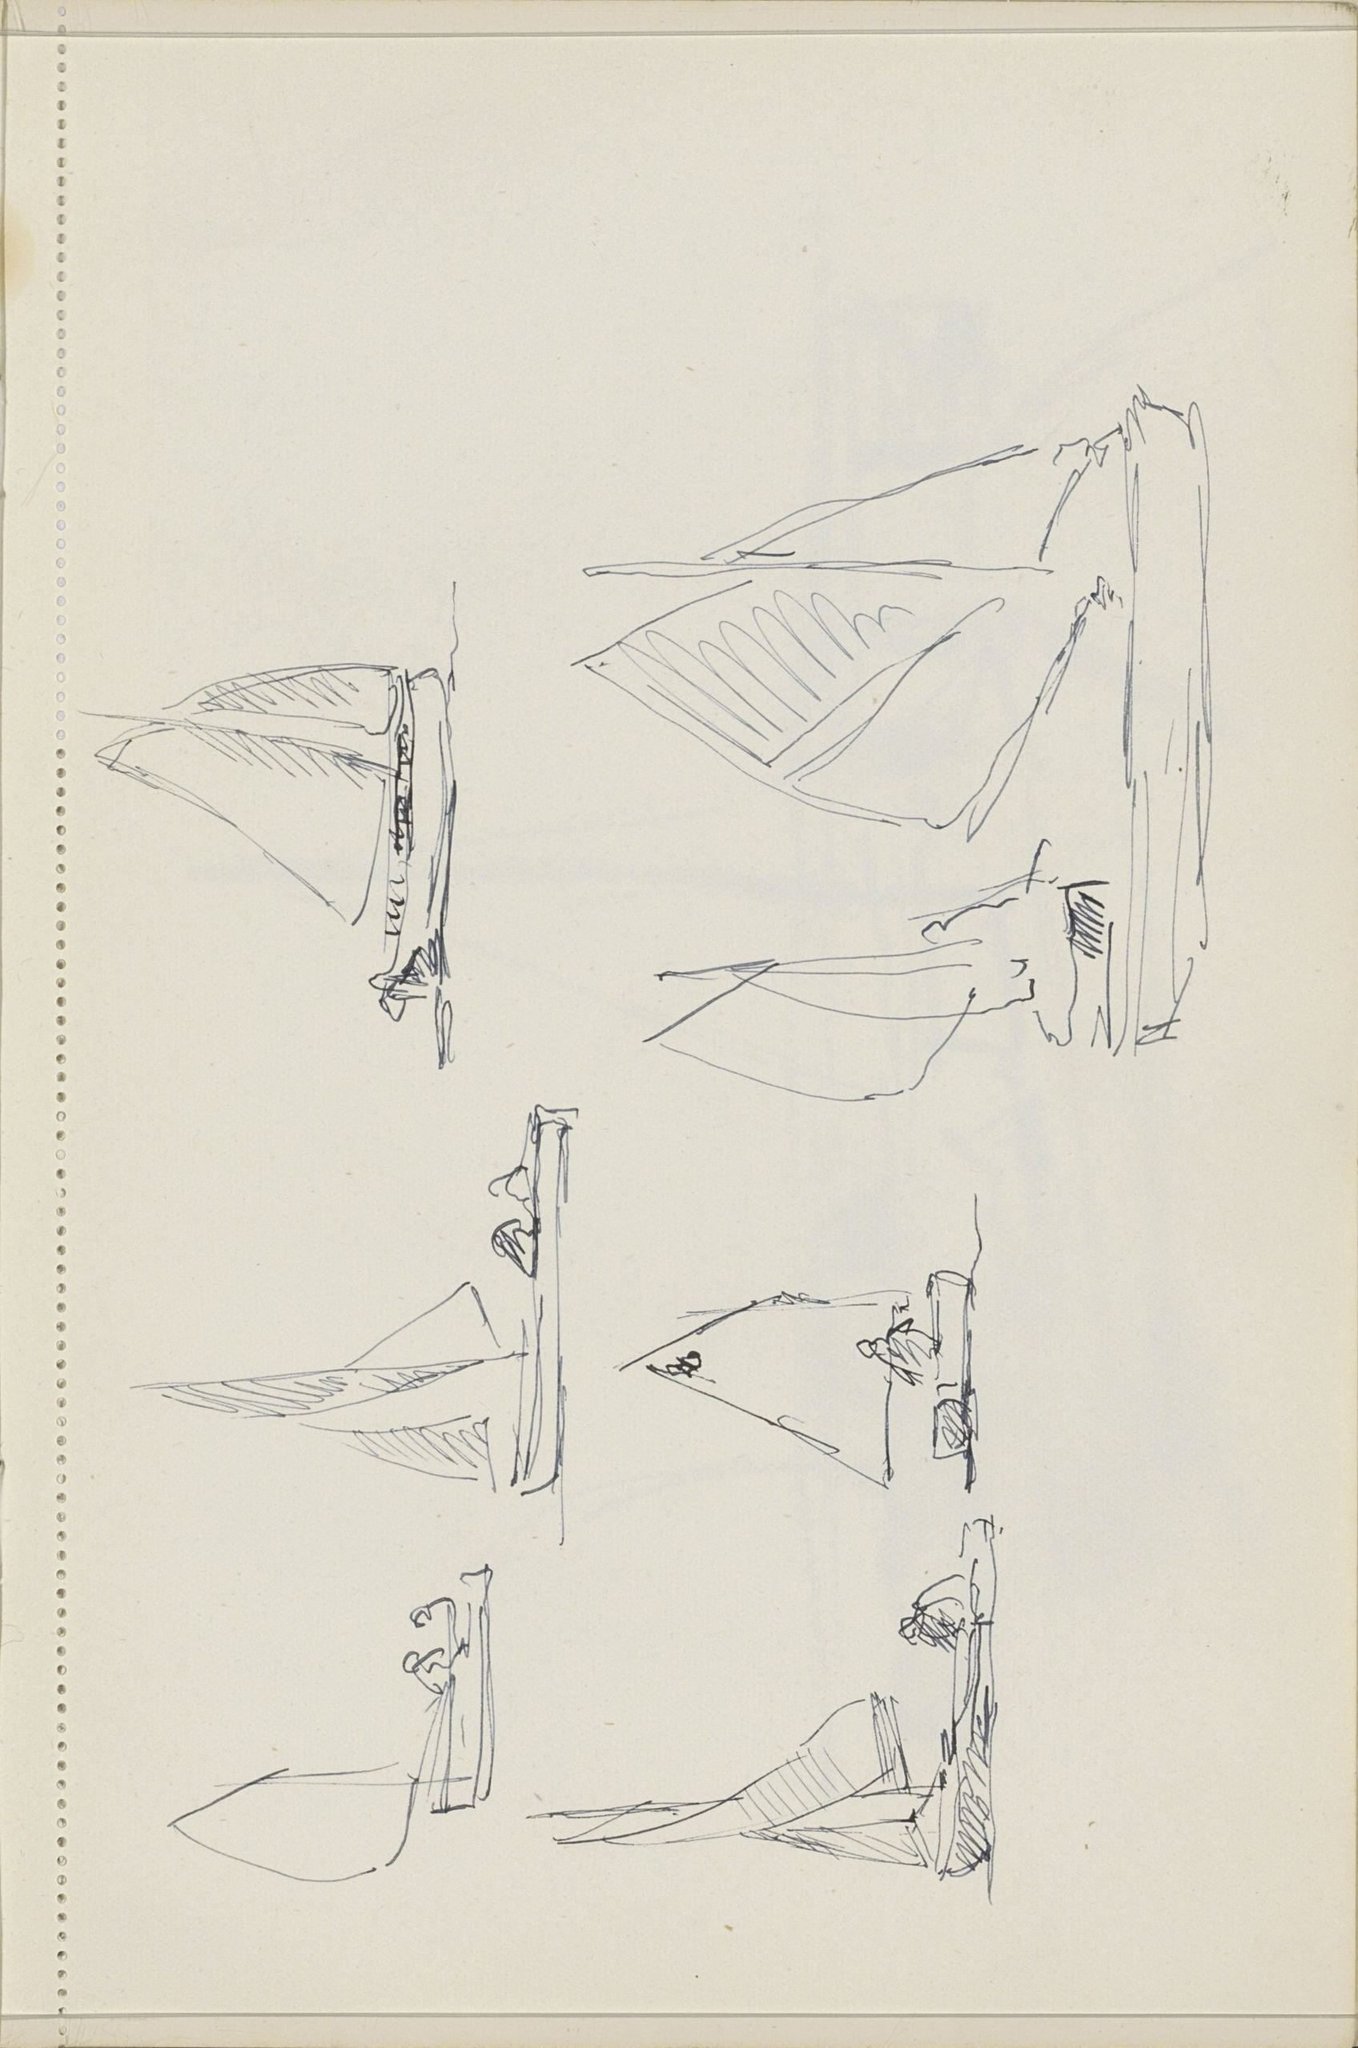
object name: sketchbook leaf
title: Zes zeilboten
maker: cornelis vreedenburgh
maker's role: draughtsman, print maker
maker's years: 1880-1946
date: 1890-1946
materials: ink, paper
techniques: pen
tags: sailing-ship, sailing-boat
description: Blad 9 recto uit een schetsboek met uit 75 bladen.